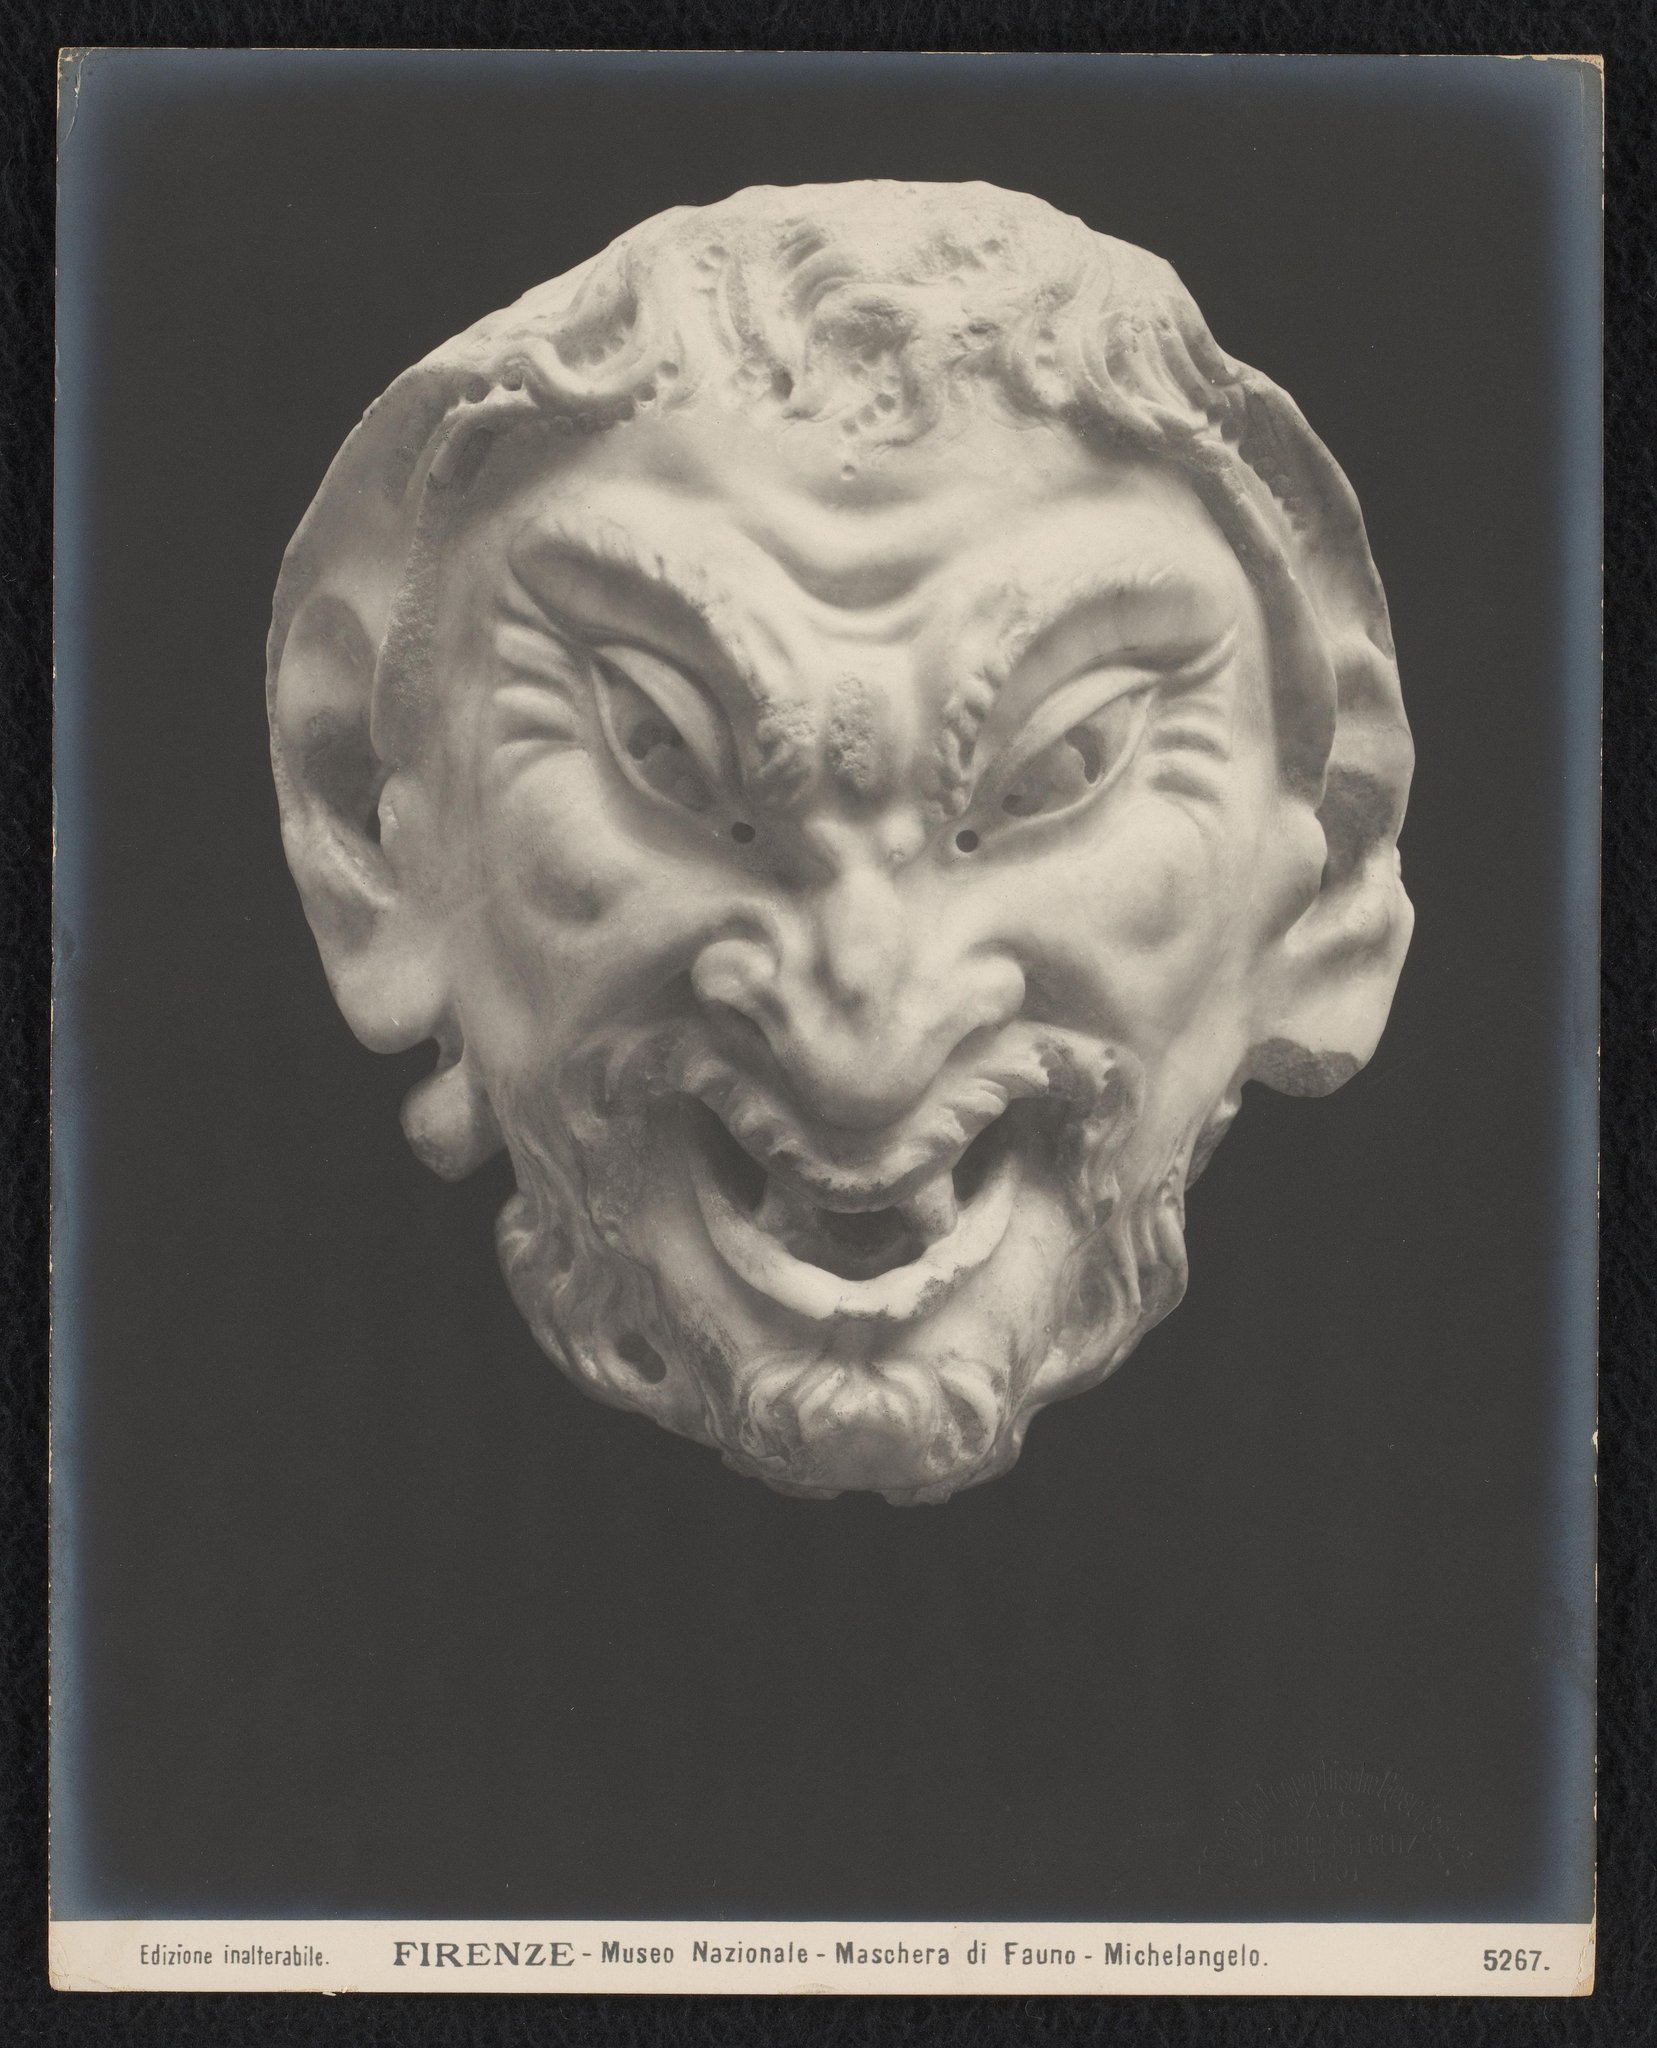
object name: photograph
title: Museo Nazionale - Maschera di Fauno - Michelangelo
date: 1901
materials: paper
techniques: gelatin silver print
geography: florence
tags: head (human), piece of sculpture, reproduction of a piece of sculpture, satyr(s) (in general)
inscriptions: collector's mark: ‘RIJKS SCHOOL VOOR KUNSTNIJVERHEID/ GROEP’, inscription: ‘Edizione inalterabile.’, number: ‘5267.’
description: Deze foto maakt deel uit van een omslag.